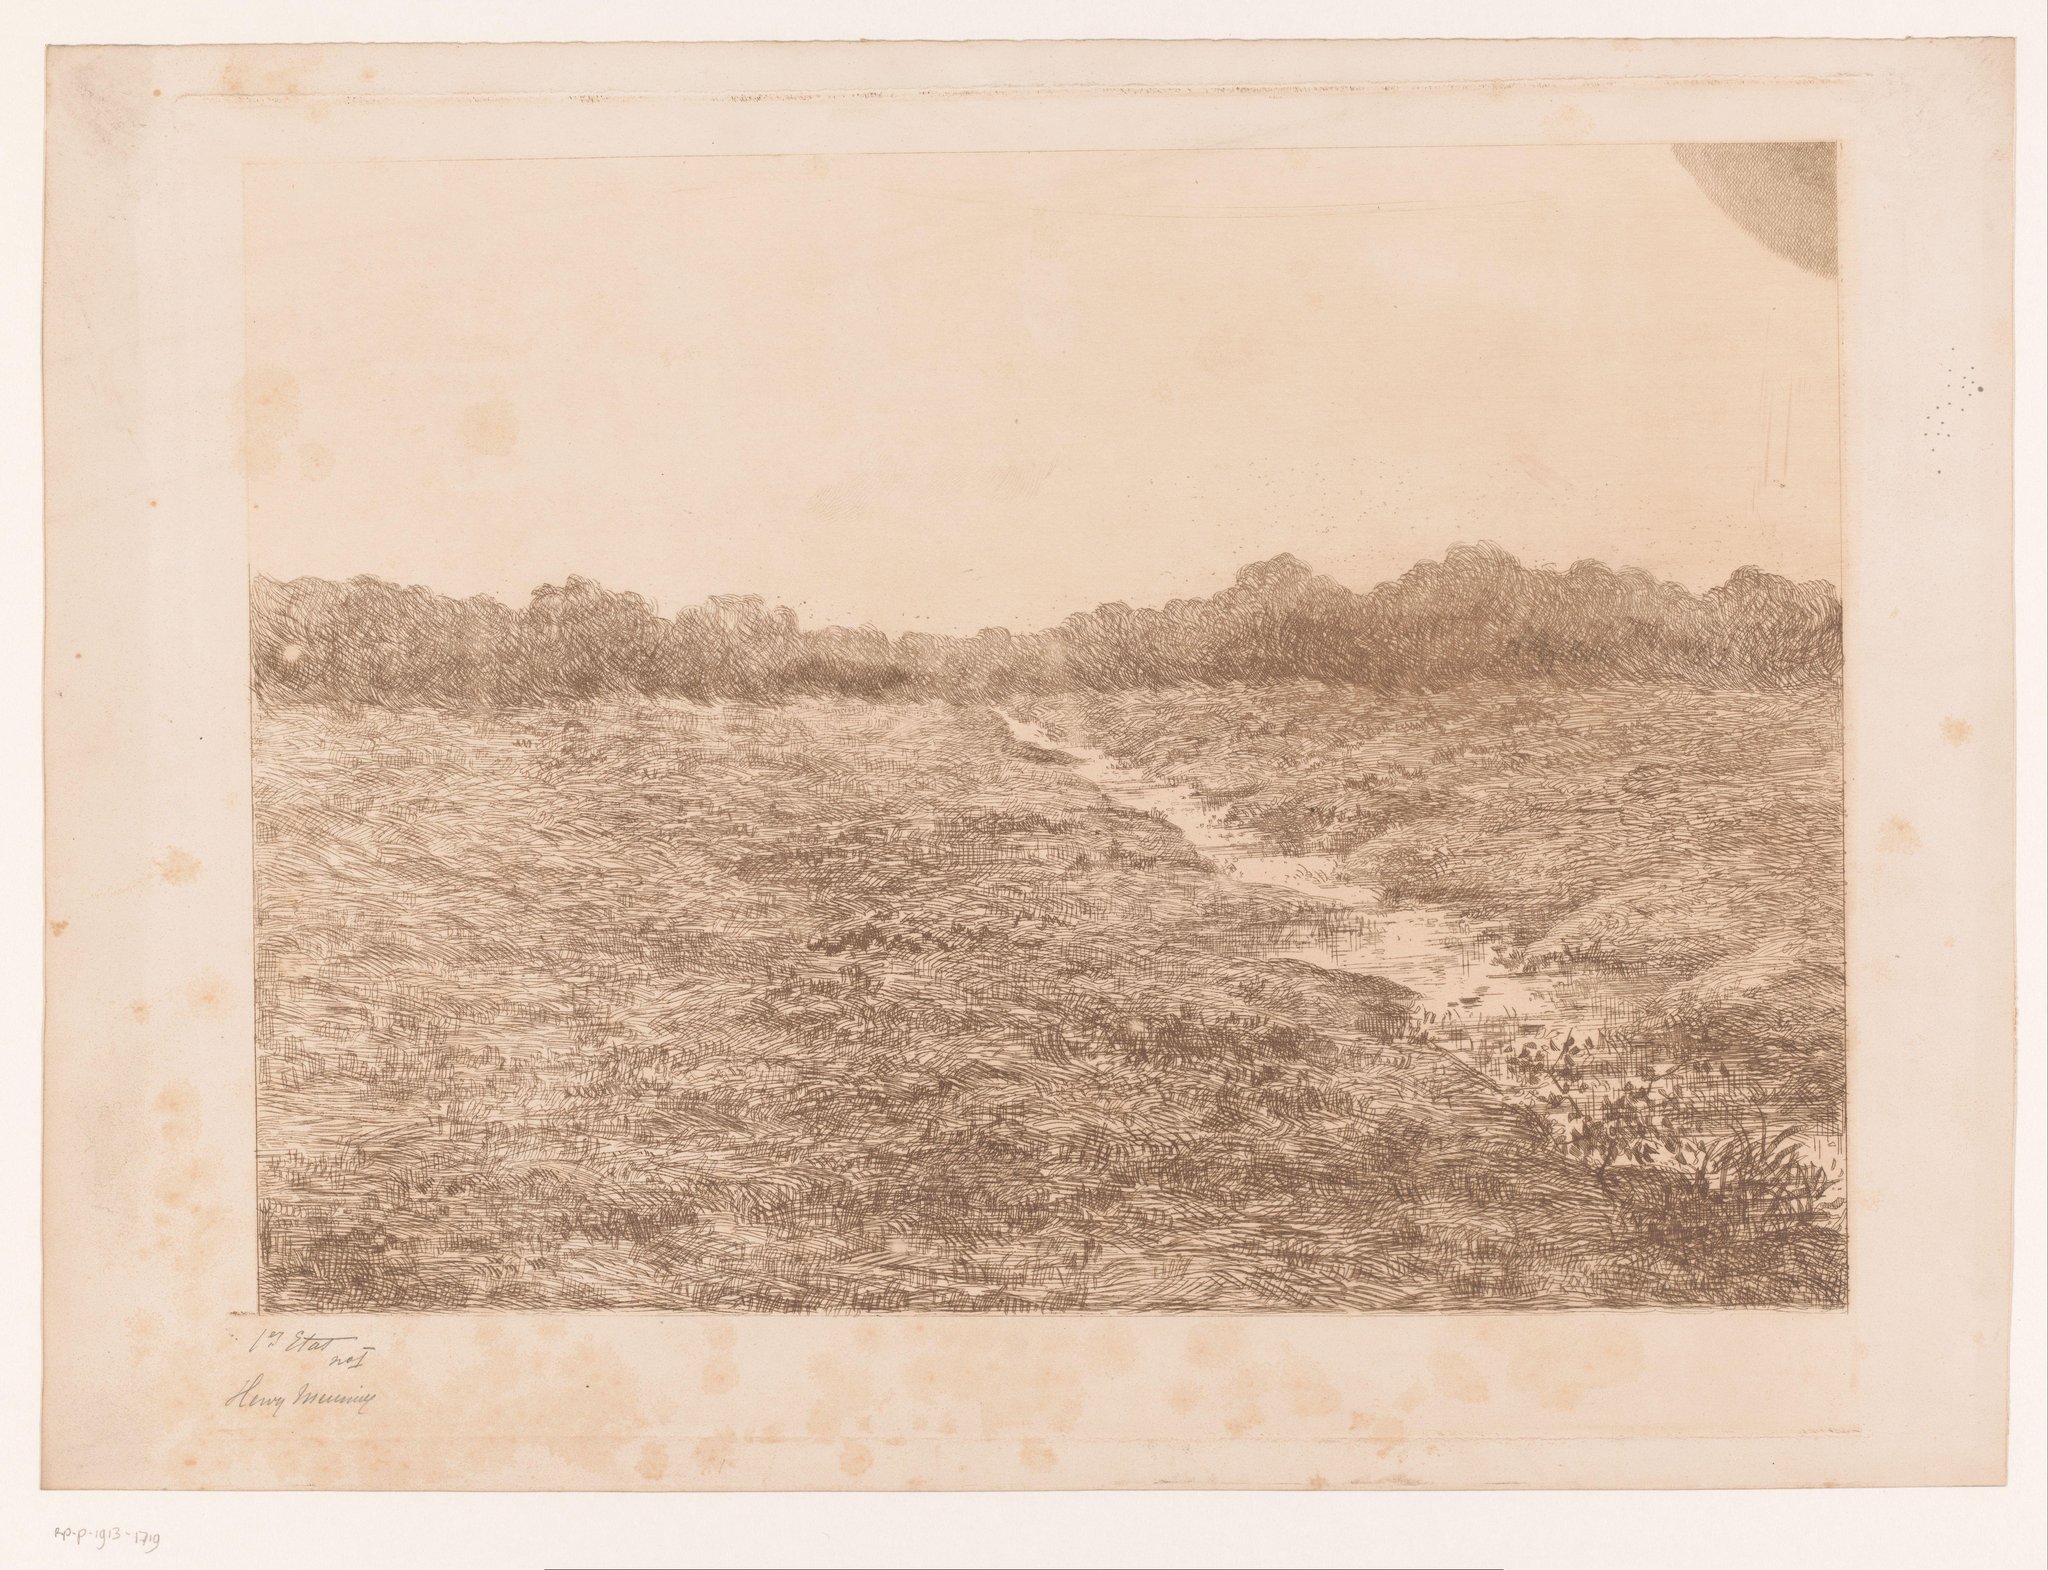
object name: print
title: Vlak landschap met beek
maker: marc henry meunier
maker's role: print maker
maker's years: 1873-1922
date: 1893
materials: paper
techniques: etching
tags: morning, brook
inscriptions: collector's mark: Lugt 2228, inscription: ‘1er Etat, no I’